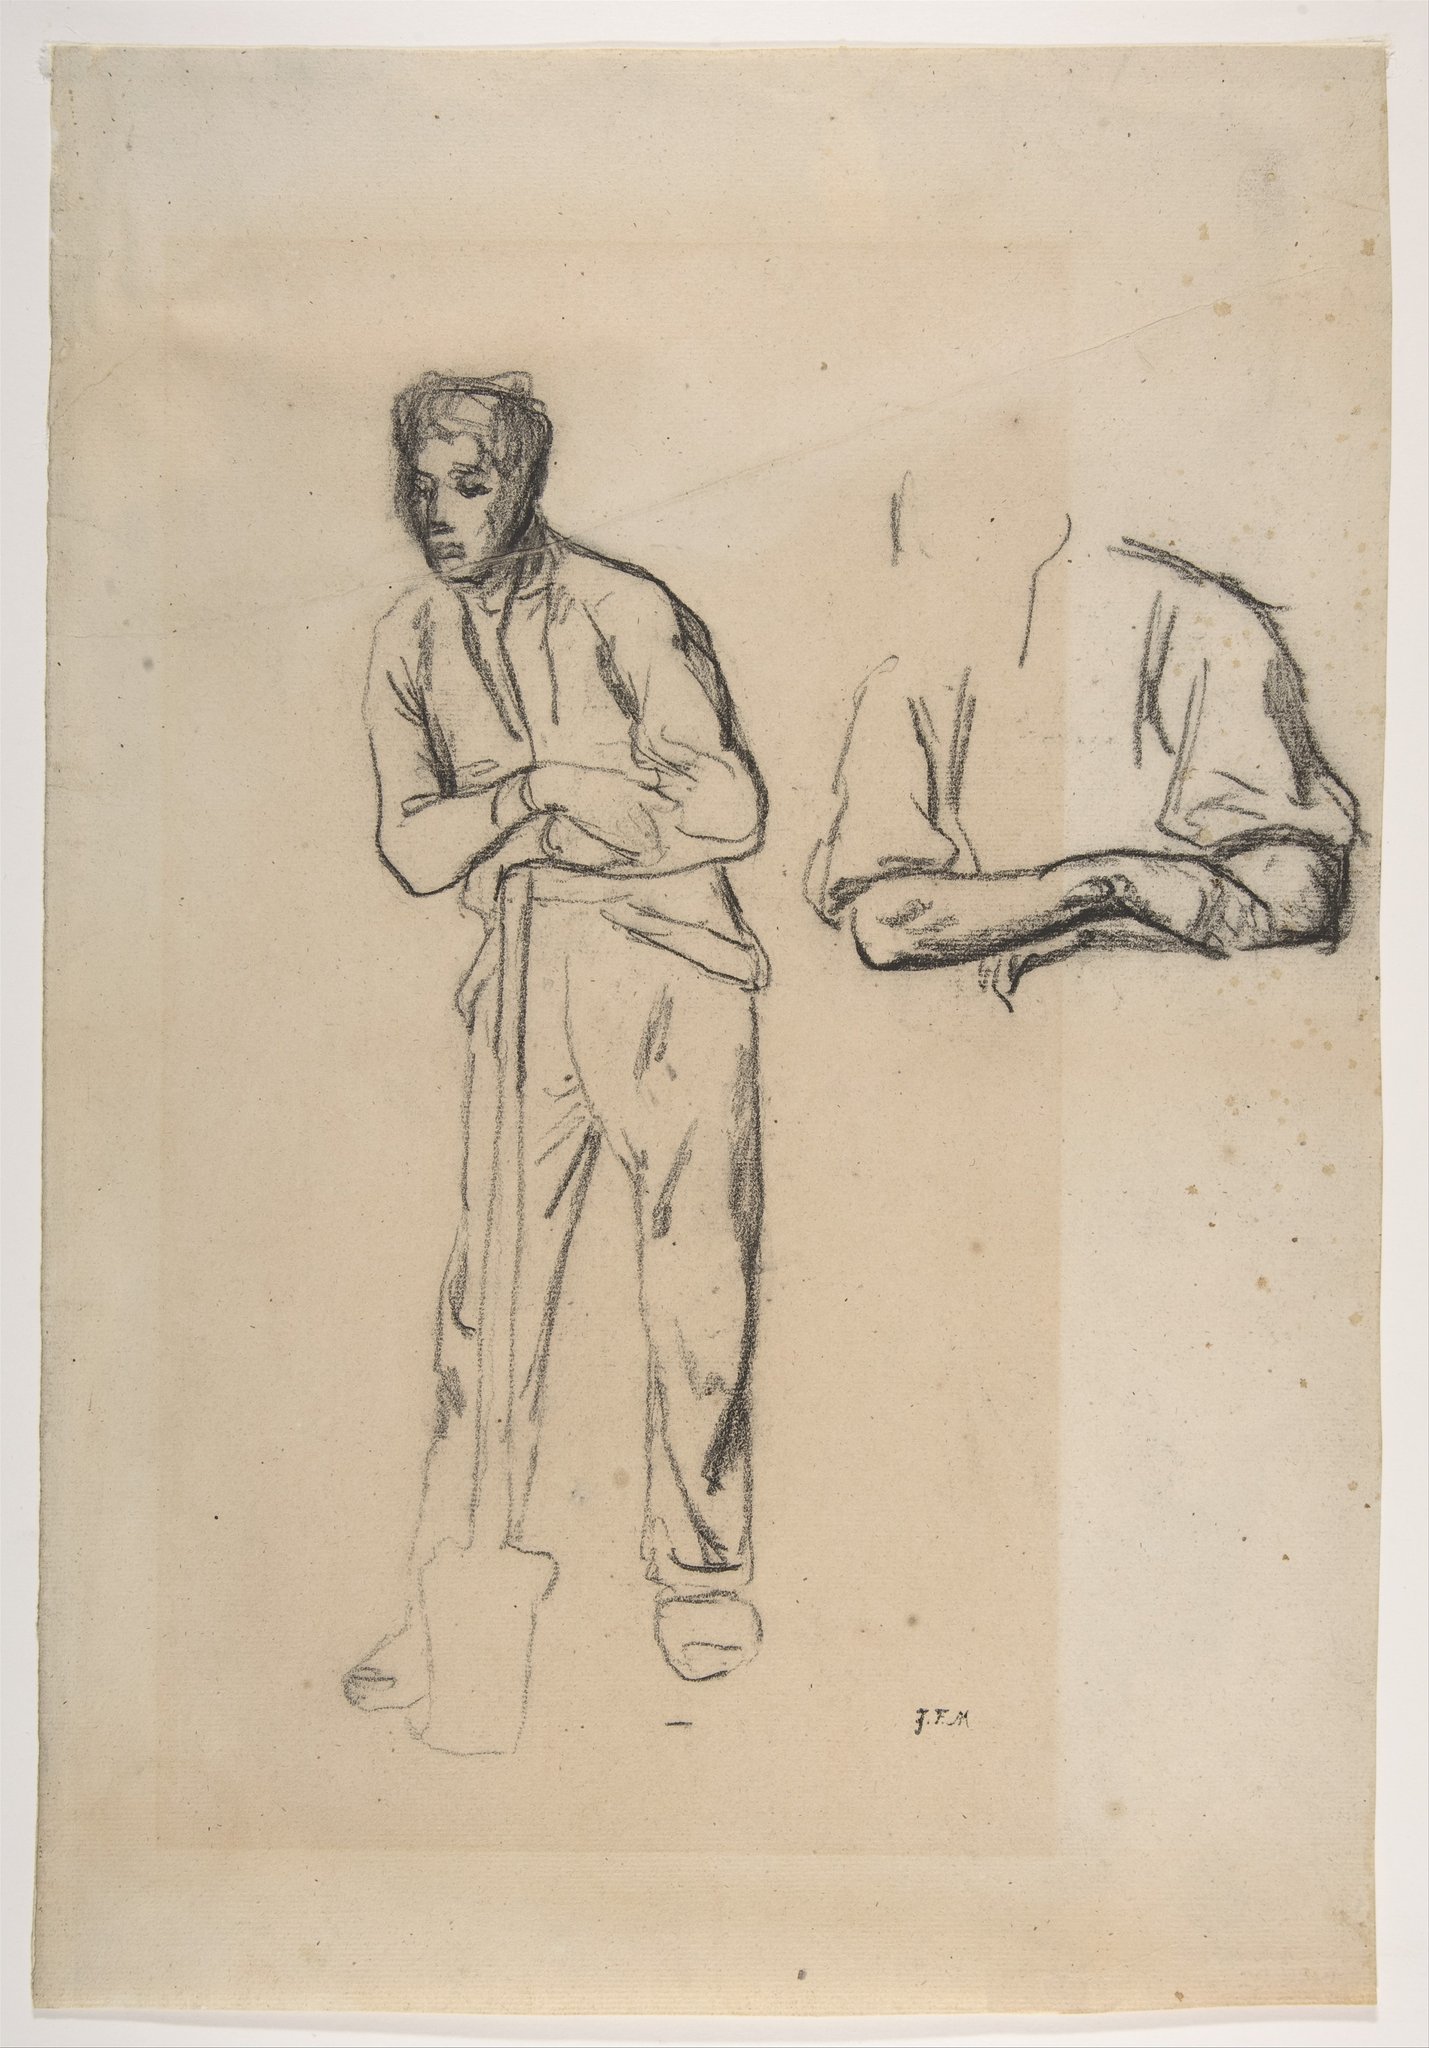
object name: drawing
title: Man with a Spade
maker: jean-françois millet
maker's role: artist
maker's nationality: french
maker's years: 1814-1875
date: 1855-1858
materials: crayon, paper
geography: france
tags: men,tools